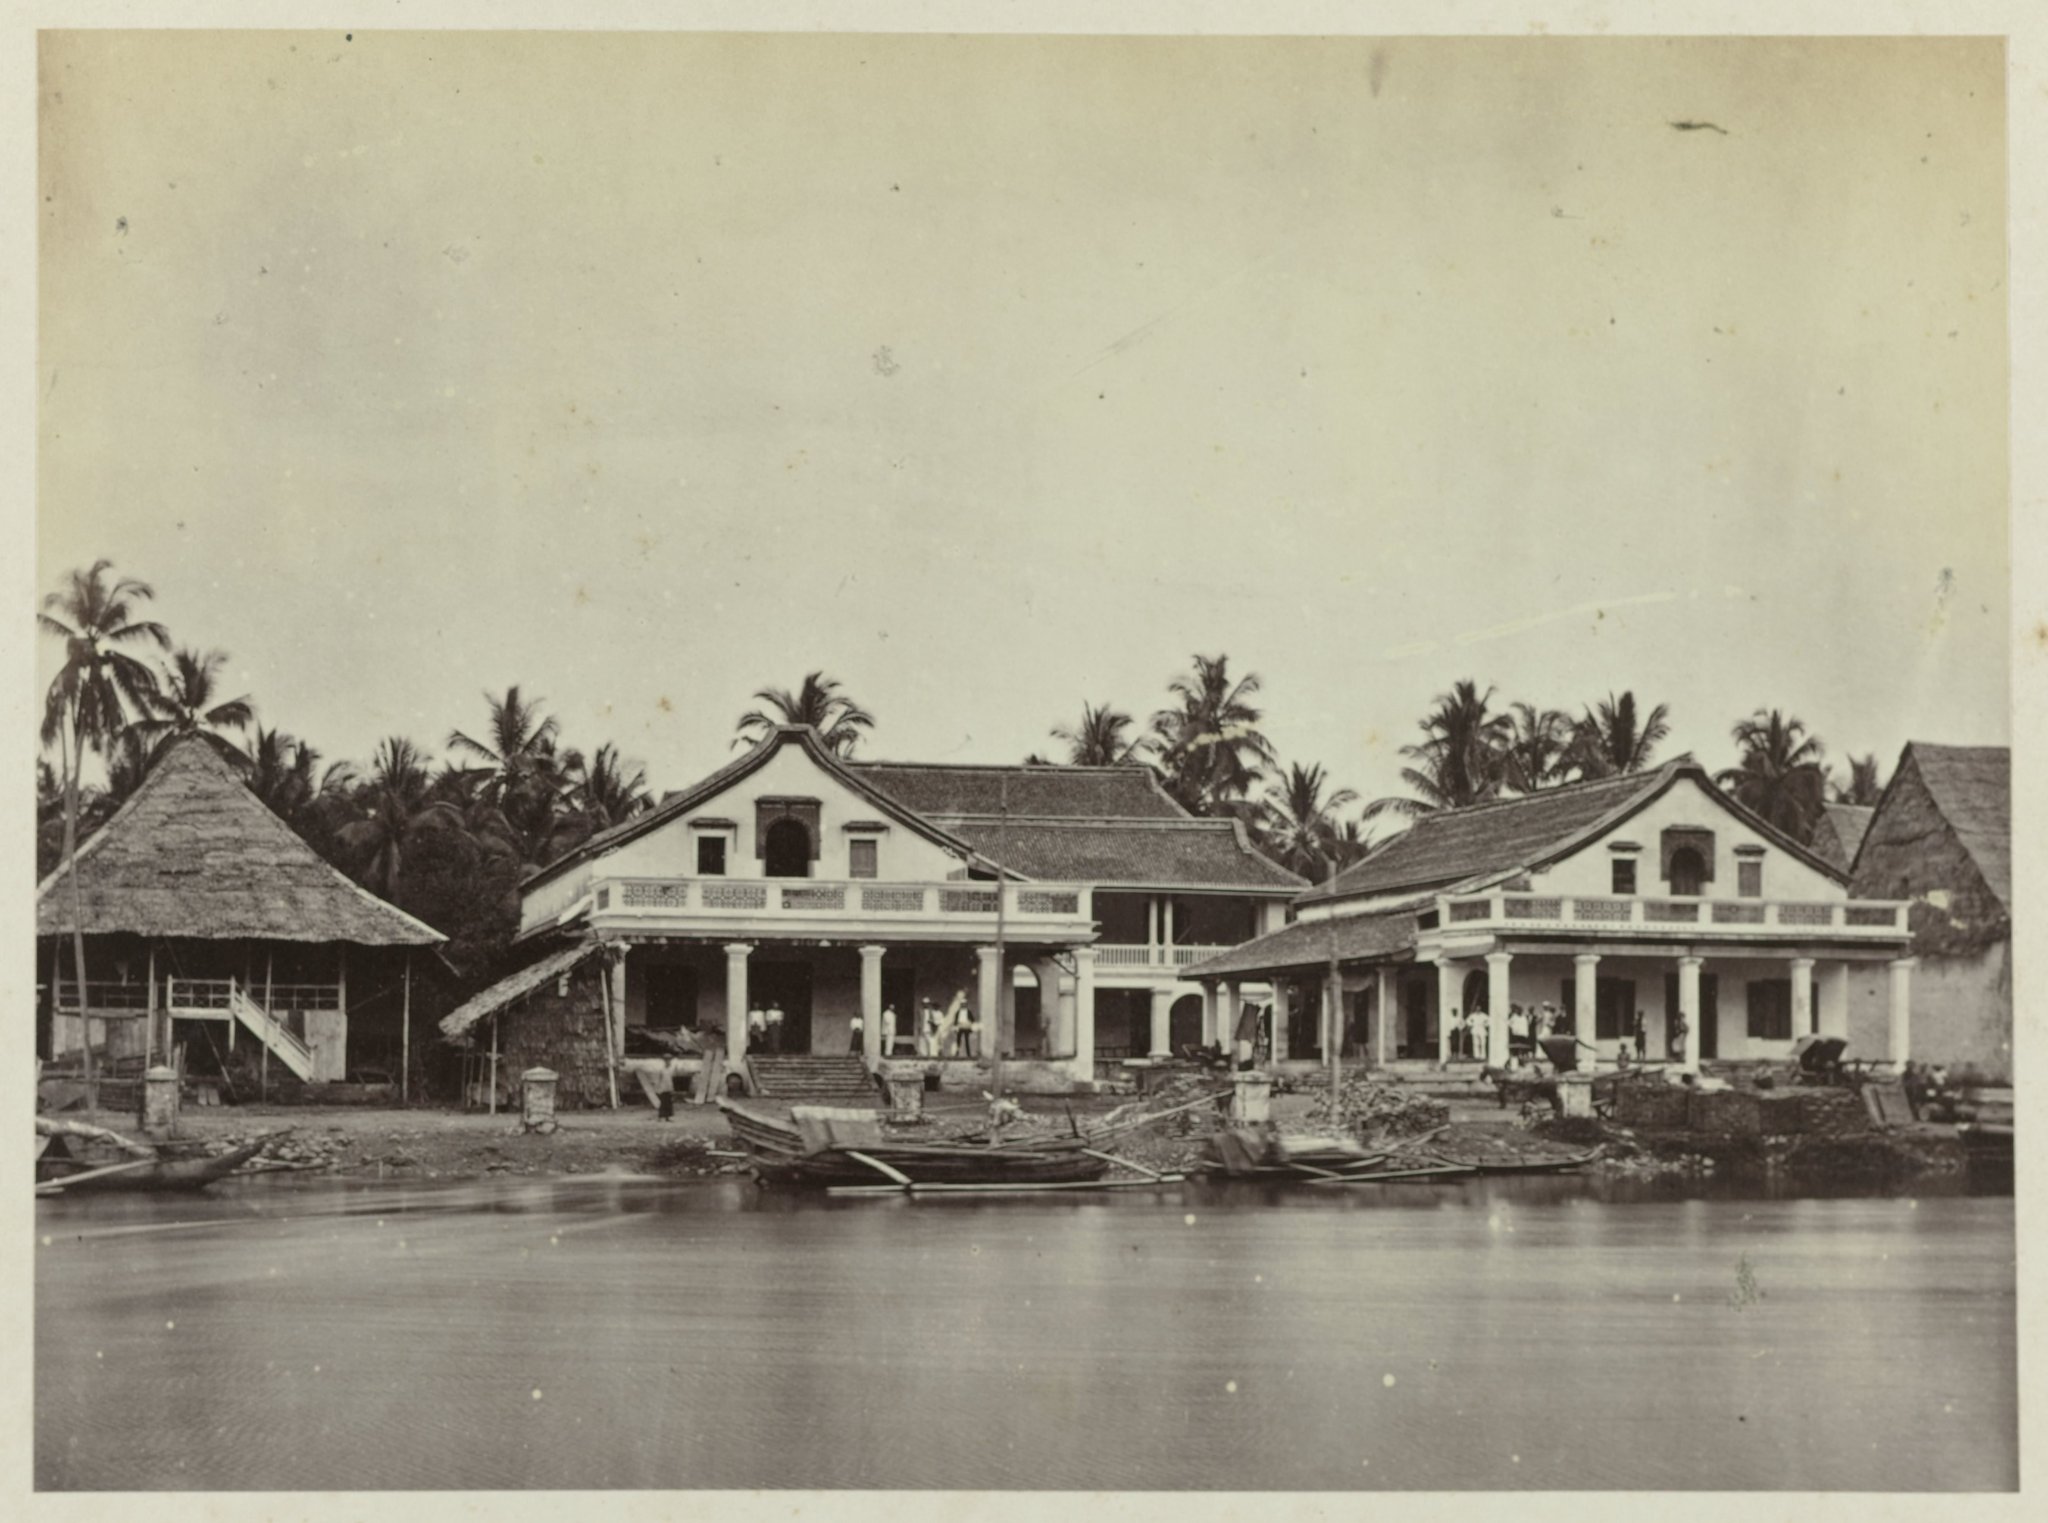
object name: photograph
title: Huizen aan een rivier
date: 1863-1869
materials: photographic support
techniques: albumen print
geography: java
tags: village, java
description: Gezicht op enkele grote huizen gebouwd aan de oever van een rivier. Onderdeel van het groene fotoalbum met foto's van Java, uit het bezit van apotheker Specht-Grijp, die in 1865 vanuit Batavia naar Nederland terugkeerde.